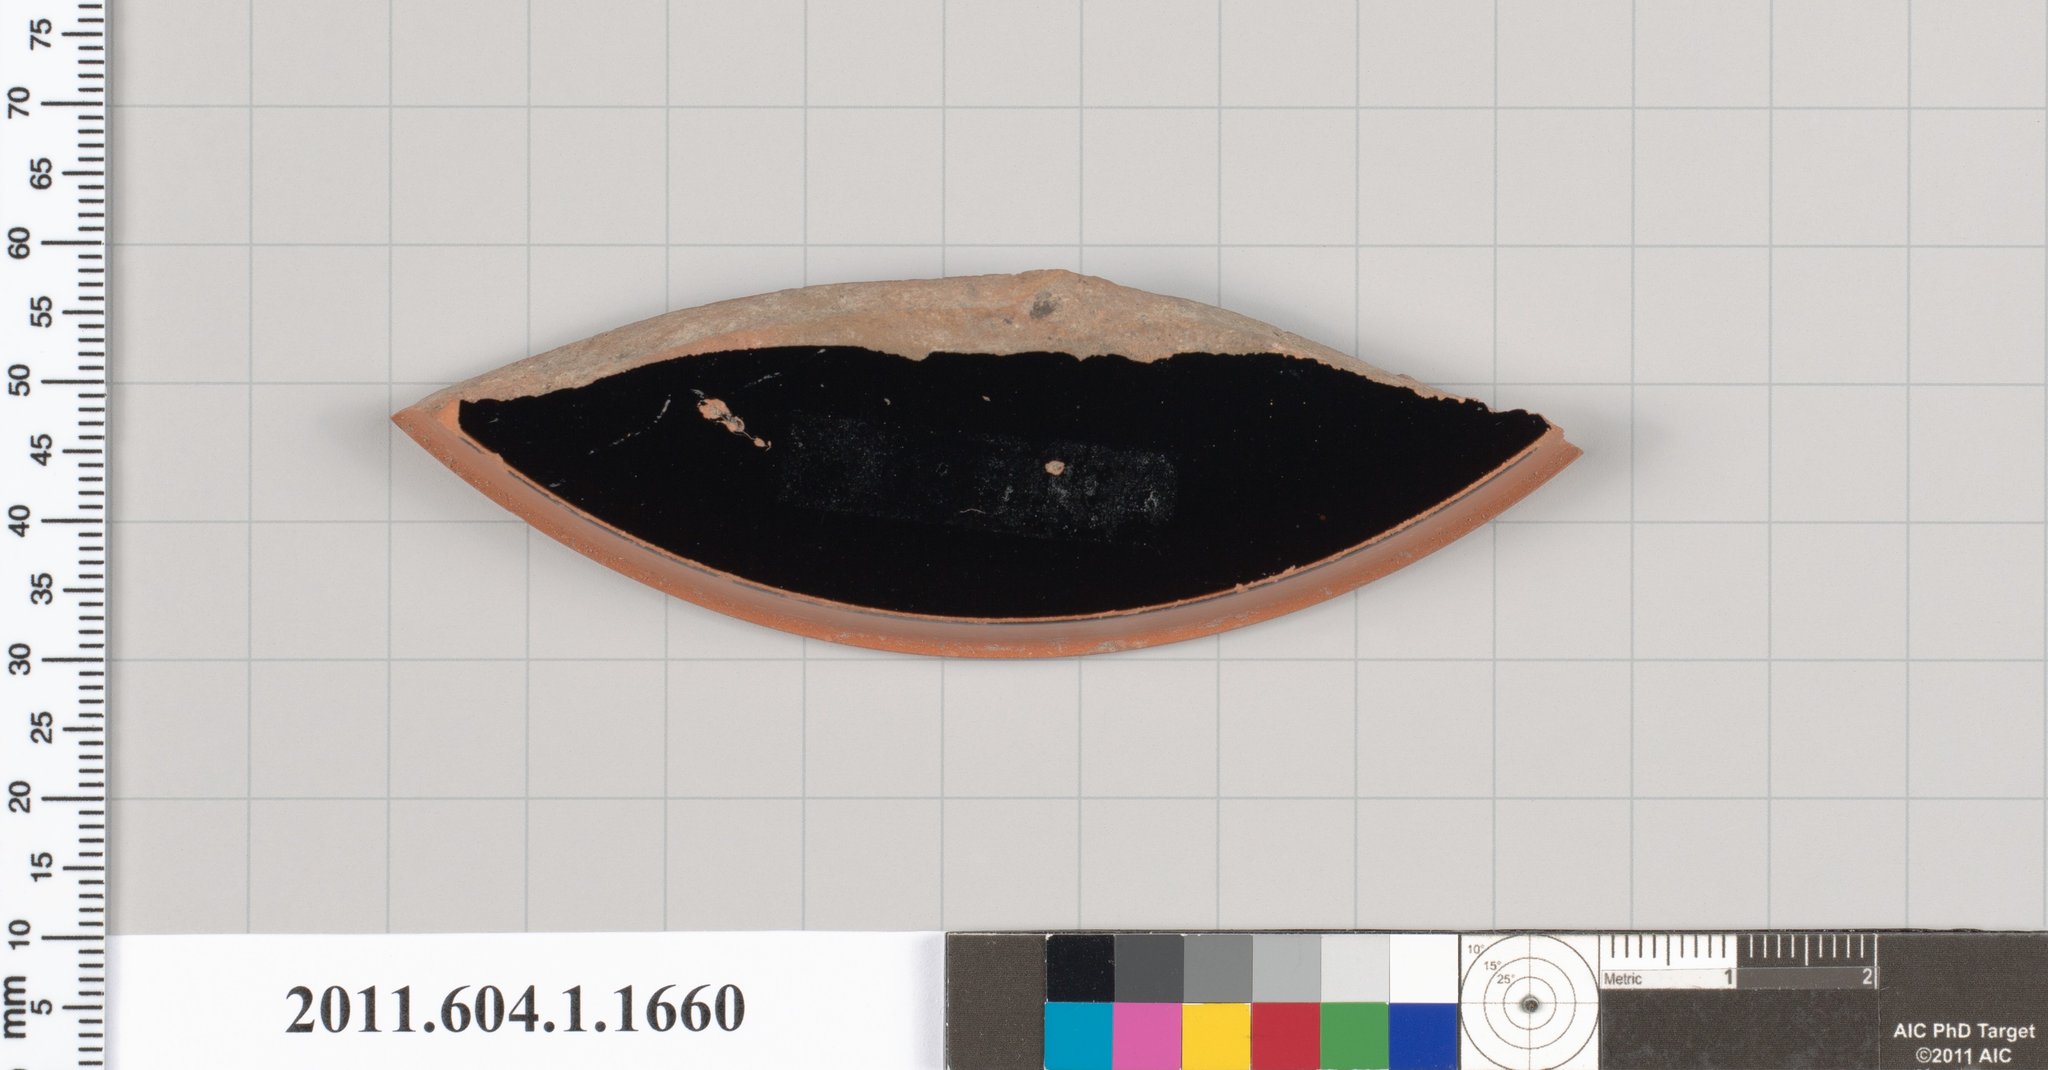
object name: kylix fragment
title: Terracotta fragment of a kylix (drinking cup)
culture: greek, attic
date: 530-510 BCE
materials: terracotta